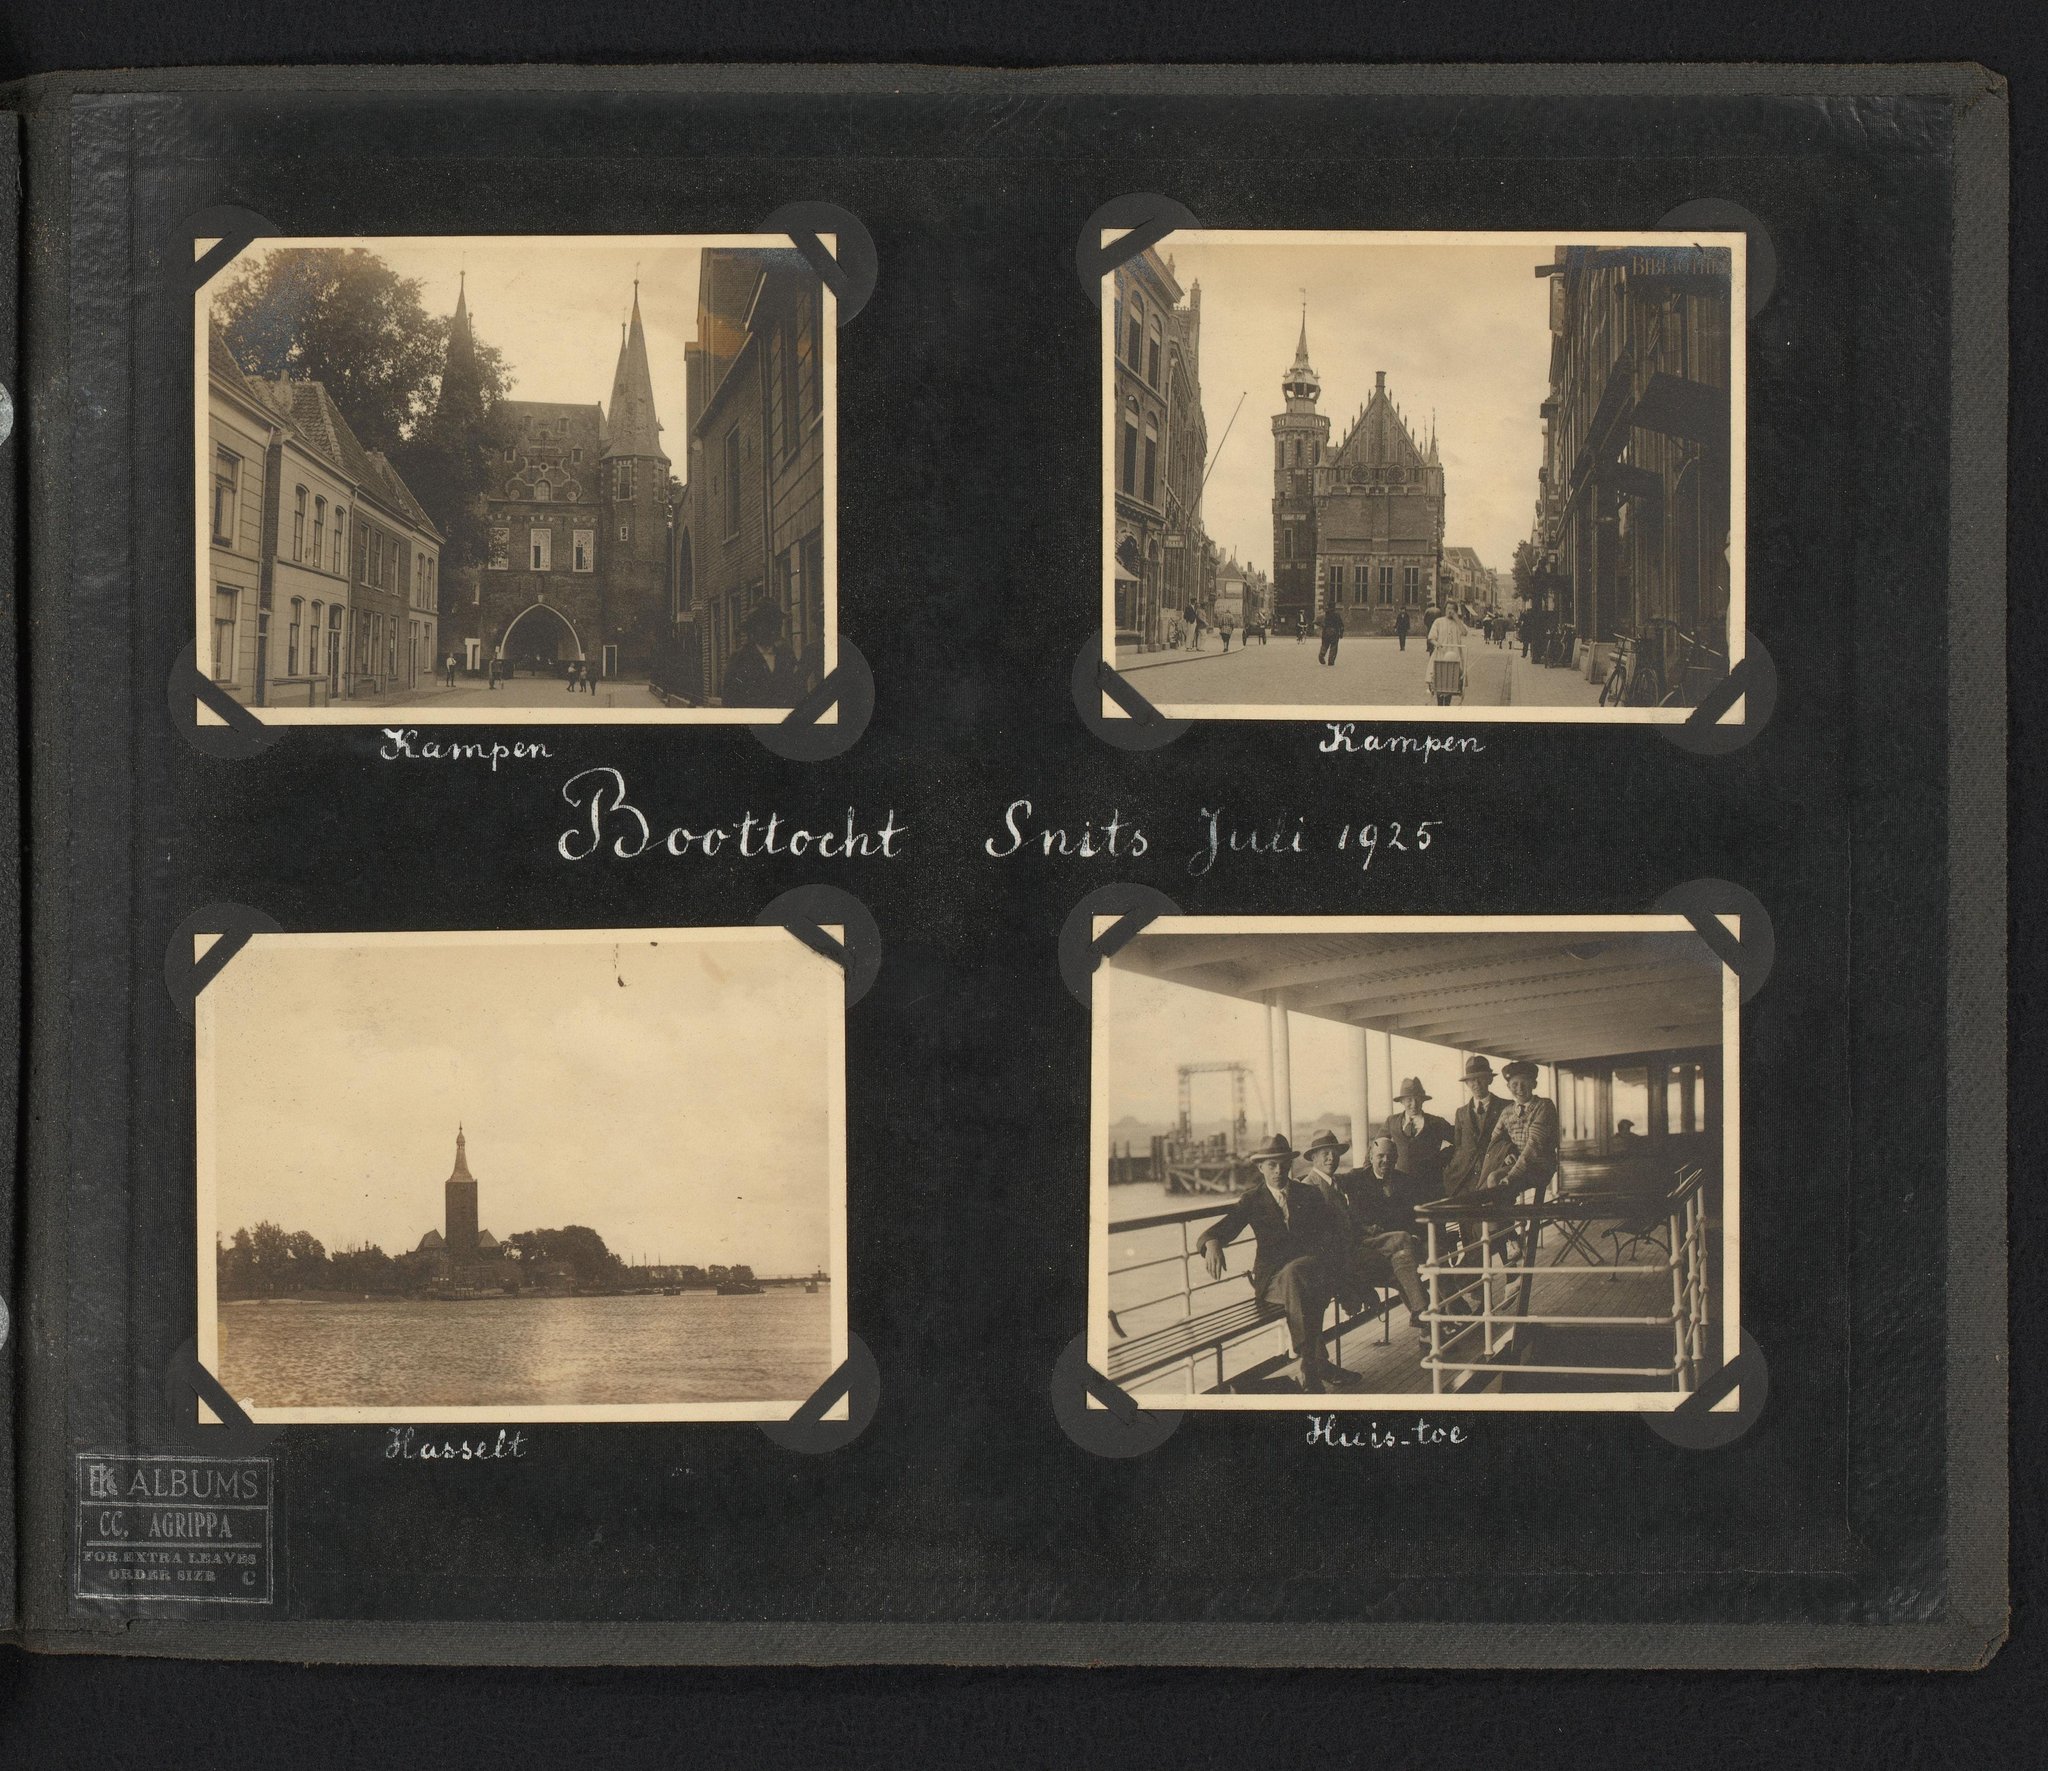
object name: album leaf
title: Vier foto's van een boottocht met zeilboot de Snits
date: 1907-1925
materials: paper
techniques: gelatin silver print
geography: overijssel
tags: batavia, amsterdam, hendrik herman van den berg, sailing-ship, sailing-boat, city-view in general; 'veduta'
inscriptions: inscription: ‘Hasselt’, inscription: ‘Huis-toe’, inscription: ‘Kampen’, inscription: ‘Kampen’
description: Deze foto's maken deel uit van een album.